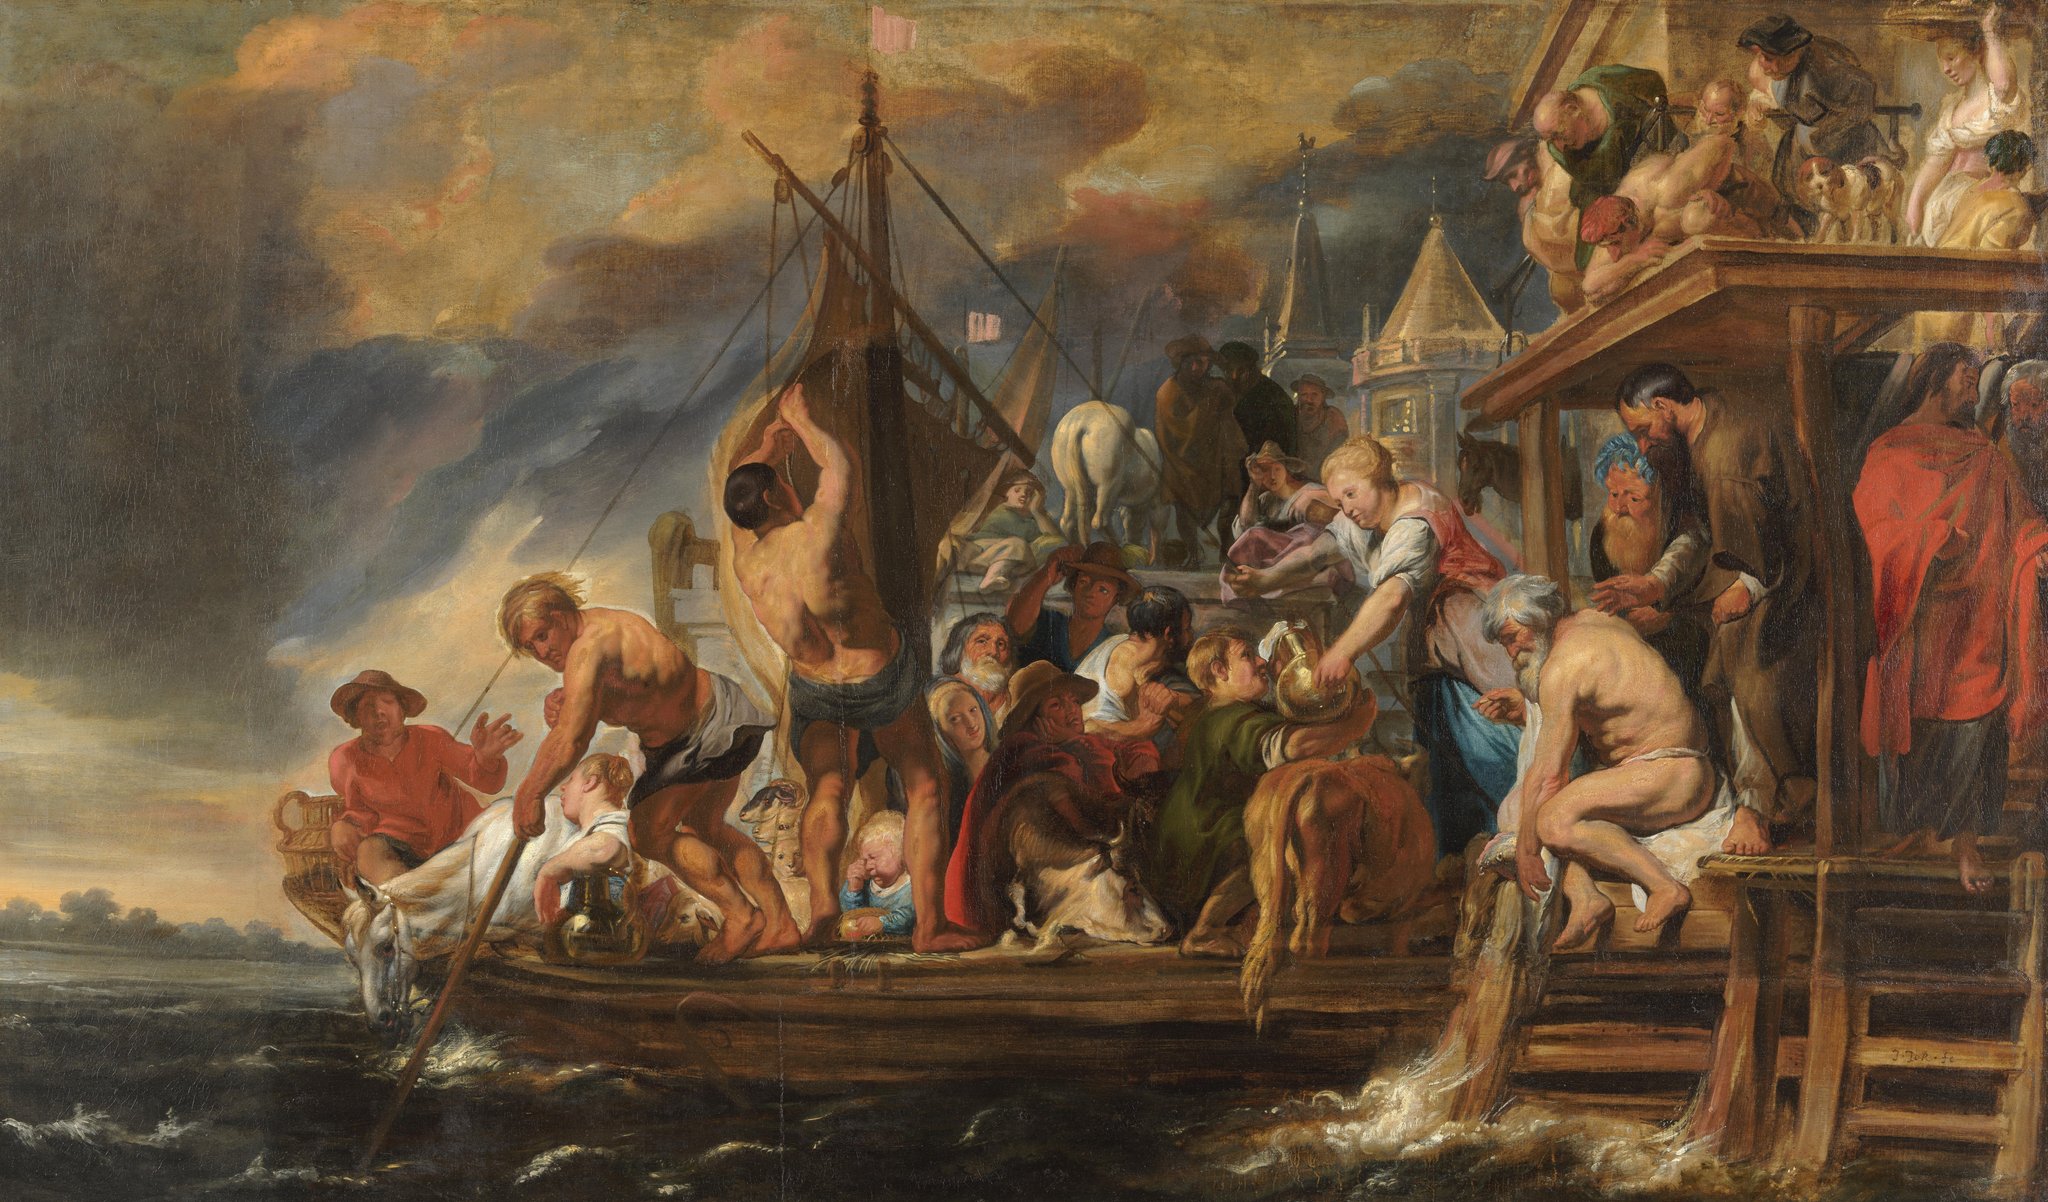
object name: painting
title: A Ferry Departs as St Peter Finds a Coin in the Mouth of a Fish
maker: jacques jordaens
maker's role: designer, draughtsman, painter, print maker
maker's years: 1593-1678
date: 1621-1650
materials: canvas, oil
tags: peter finds a piece of money in the mouth of a fish and pays the temple tribute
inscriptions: signature, bottom right: ‘J·JOR·fe’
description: Jacob Jordaens (1593 - 1678). The miracle of the obol in the mouth of the fish, c. 1640/1650. On Jesus' instructions, Peter caught a fish which had in its mouth a silver coin, an obol. With this they were able to pay the tribute required of them. Jordaens portrayed the event beside a crowded ferry. Peter is seated on the quayside, bent over with a fish in one hand and the coin in the other. Originally the painting was smaller: strips were subsequently added on the right and at the top. The surface is extremely dirty, which hides the seams linking the different sections of canvas. Probably from the Nieuwe Zijds Huiszittenhuis (Institute for Relief for the Poor), Amsterdam Loan from the City of Amsterdam, 1885.